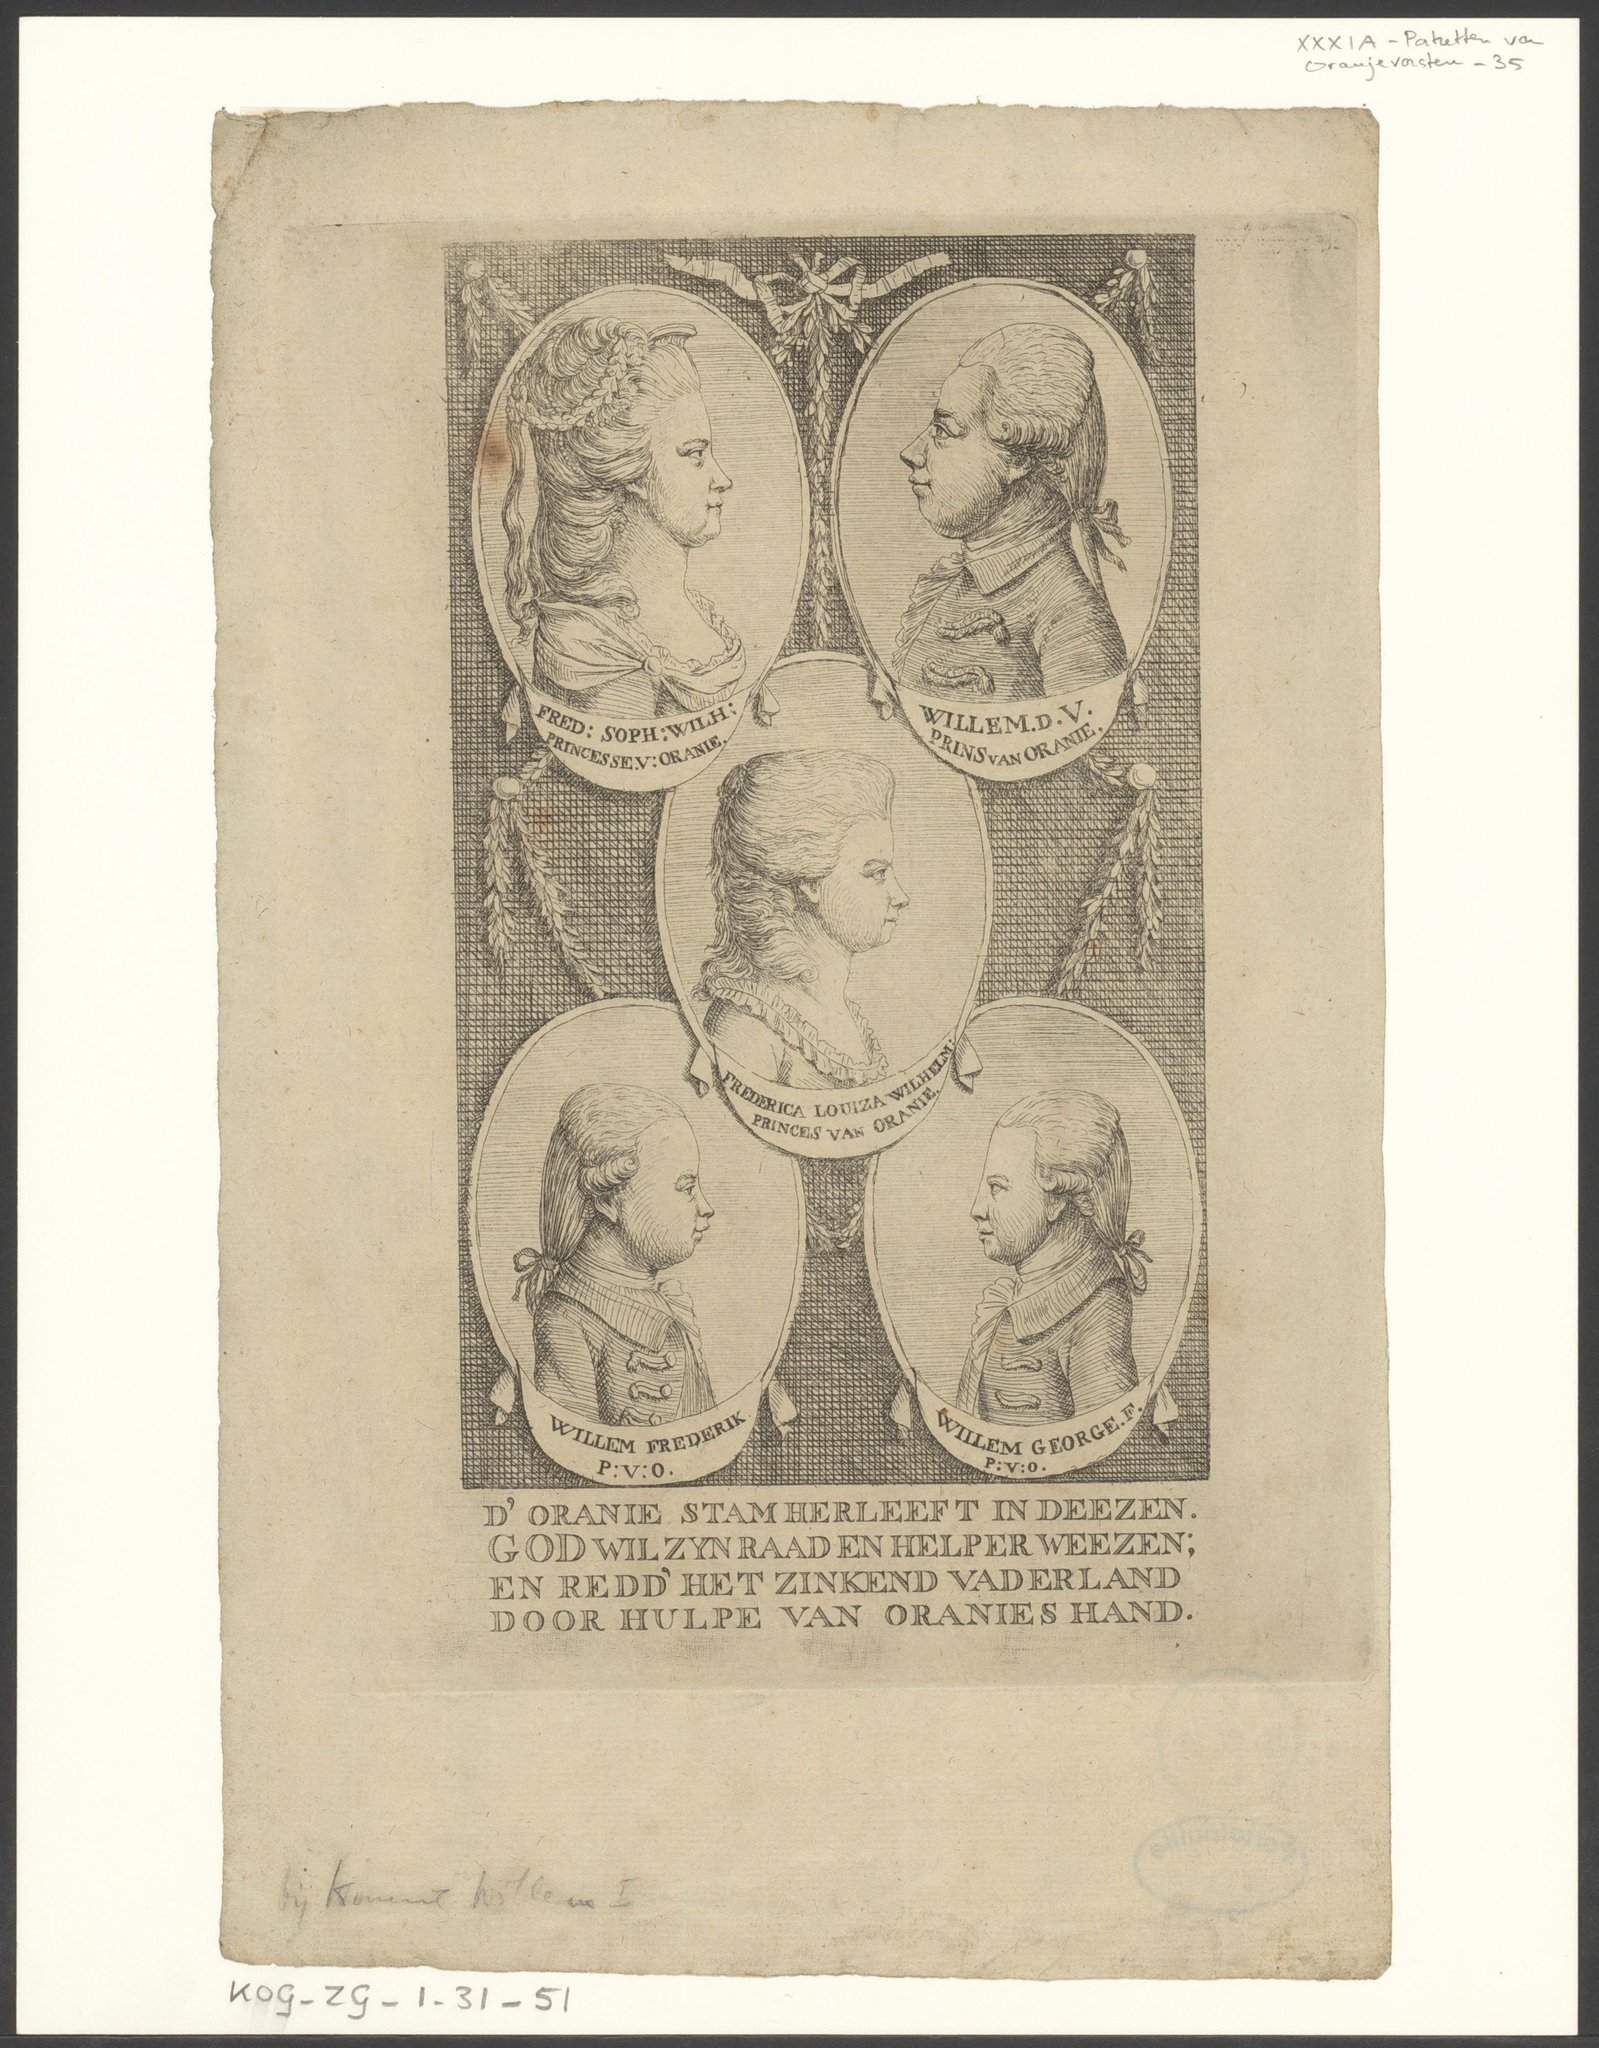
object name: print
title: Portretten van Wilhelmina van Pruisen, Willem V, prins van Oranje-Nassau, Louise, prinses van Oranje-Nassau, Willem I Frederik, koning der Nederlanden, en Frederik, prins van Oranje-Nassau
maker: johannes jelgerhuis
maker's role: draughtsman, painter, print maker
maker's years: 1770-1836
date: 1780-1849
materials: paper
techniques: etching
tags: the hague, william v (prince of orange), berlin, william i of the netherlands, wilhelmina of prussia (princess of orange), louise (prinses van oranje-nassau), willem george frederik (prins van oranje-nassau), historical persons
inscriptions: collector's mark: Lugt 1641, stamp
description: Portretten van Wilhelmina, Willem V, Louise, Willem I Frederik en Frederik. Elk in een ovaal met daaronder op een doek hun namen en titels. In de ondermarge vier regels Nederlandse tekst. Onderwerpsrubrieken binnen de Atlas Zeden en Gewoonten: Portretten, Portretten van Vorsten uit het huis van Oranje, Regeerende Vorsten, Koningen uit het huis van Oranje.